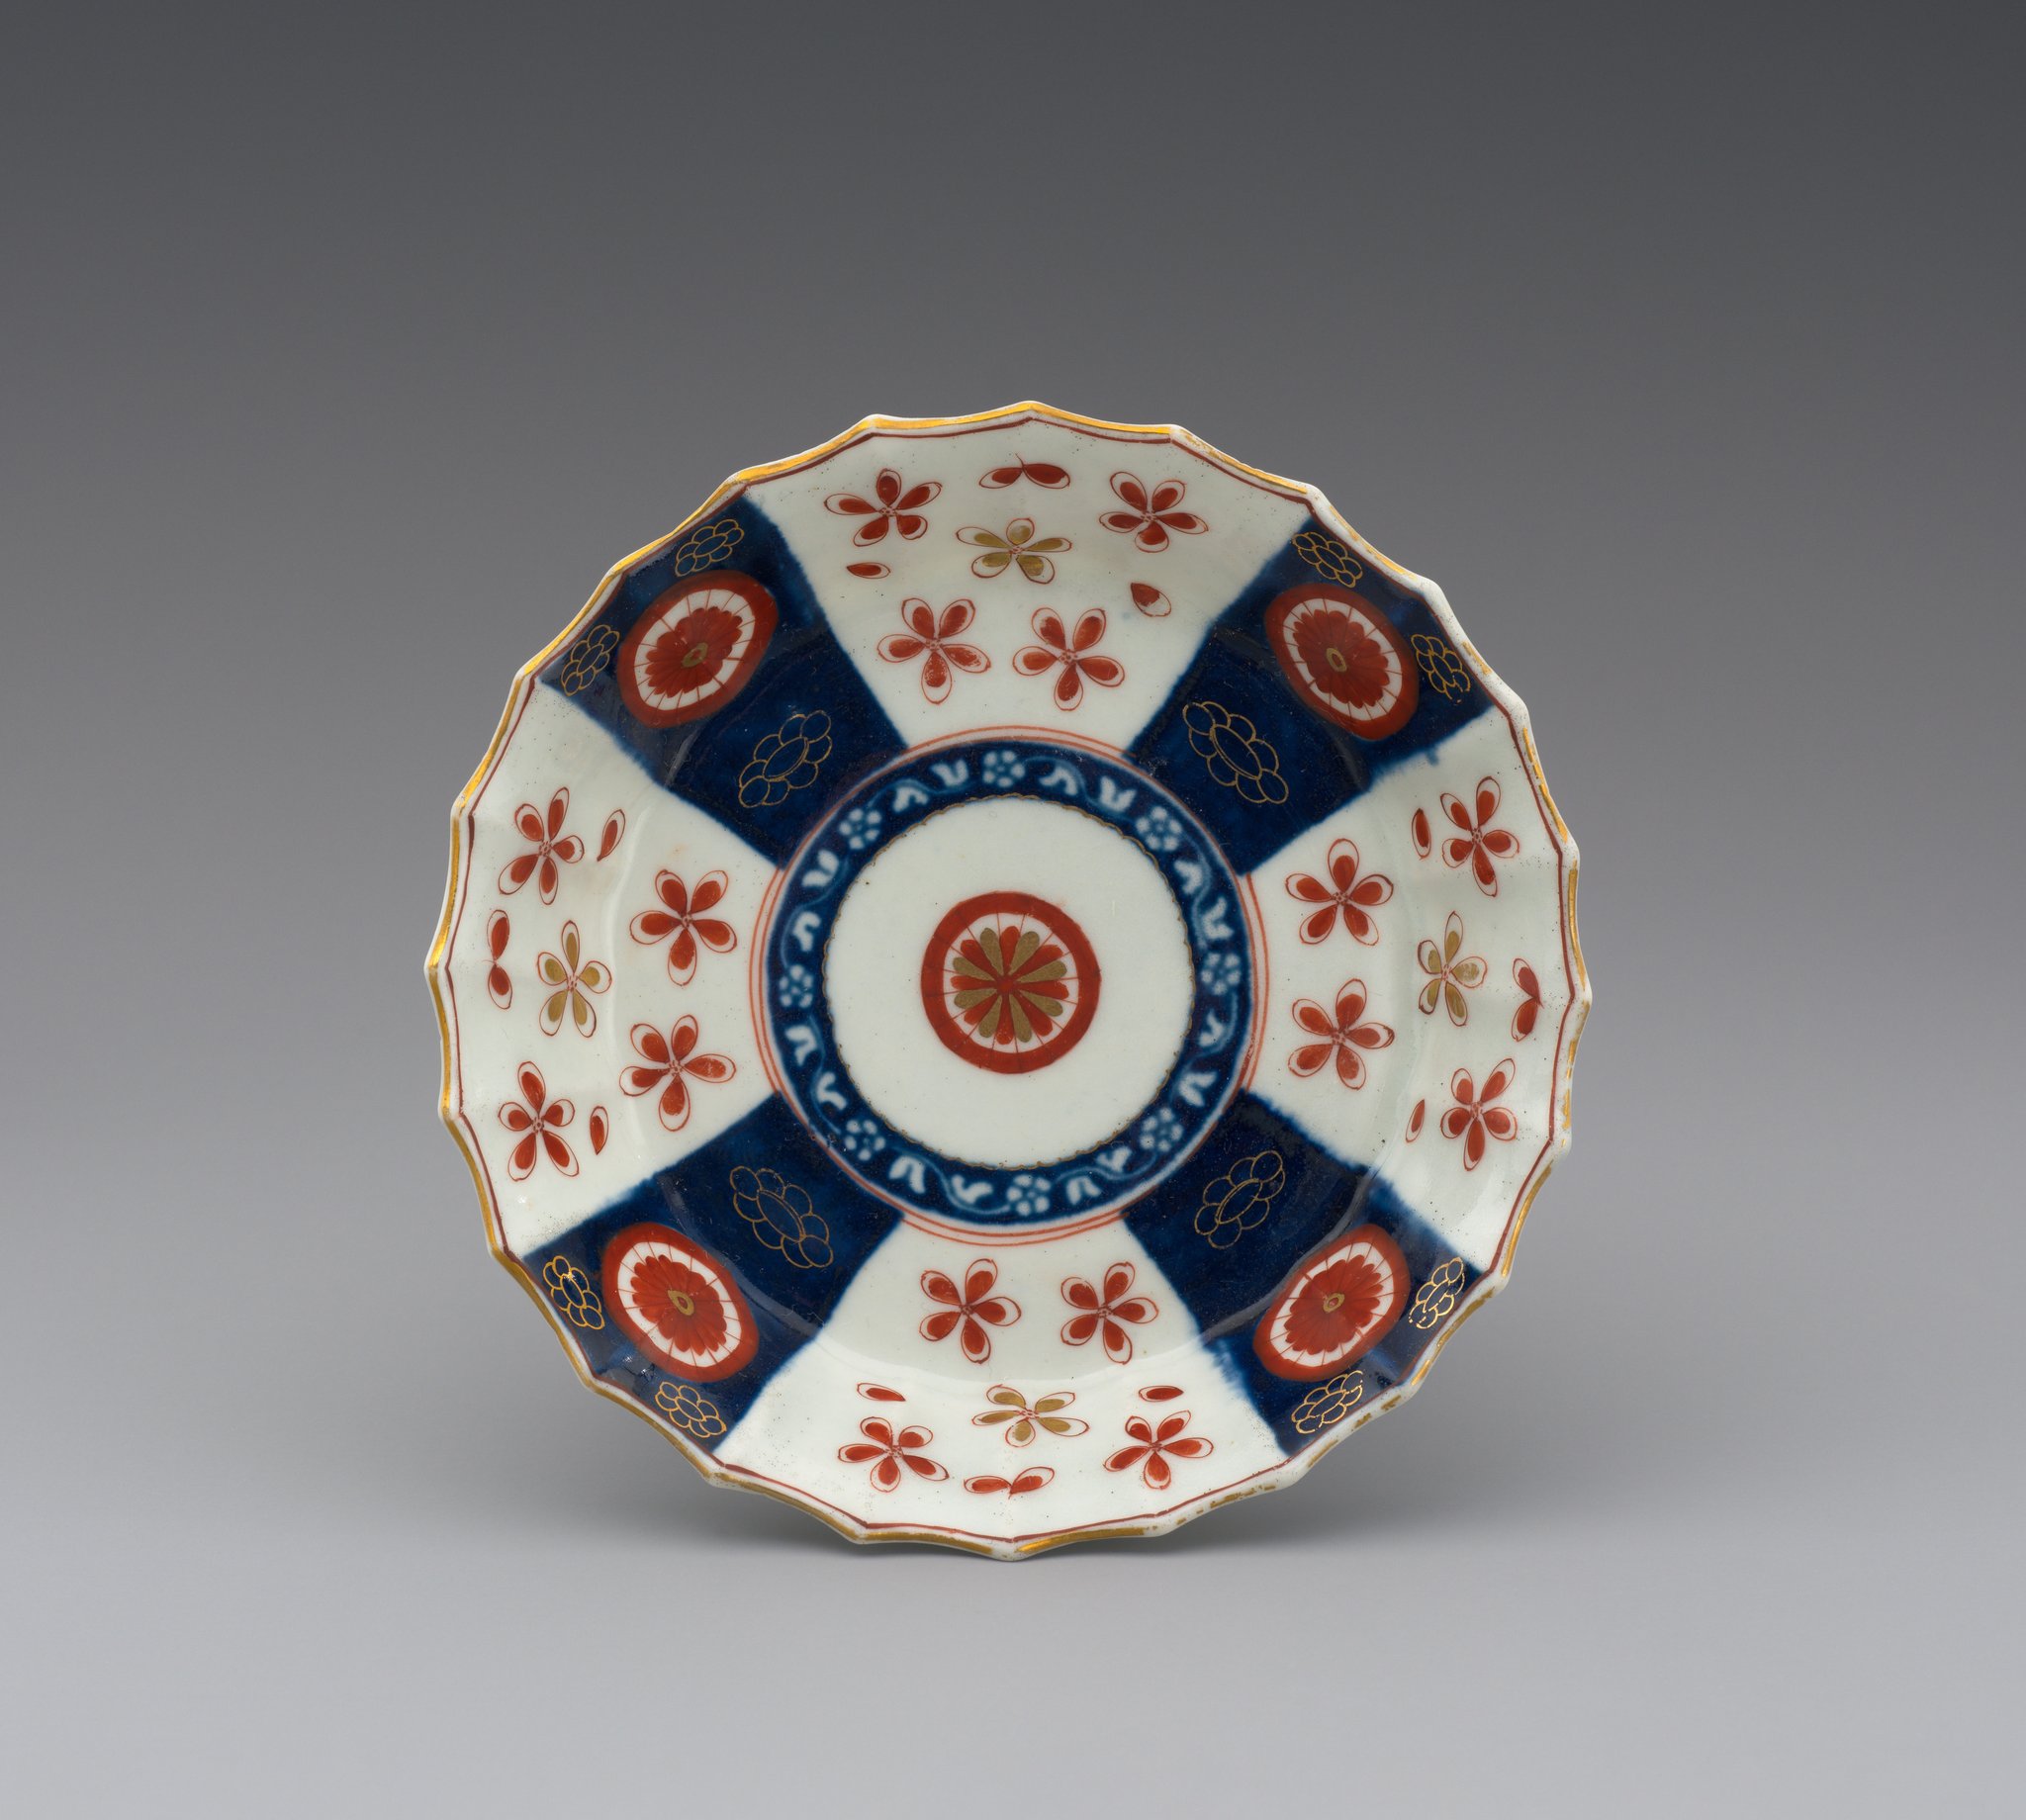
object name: saucer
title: Saucer (part of a service)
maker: worcester factory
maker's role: factory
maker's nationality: british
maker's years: 1751-2008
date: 1765-1775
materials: soft paste porcelain